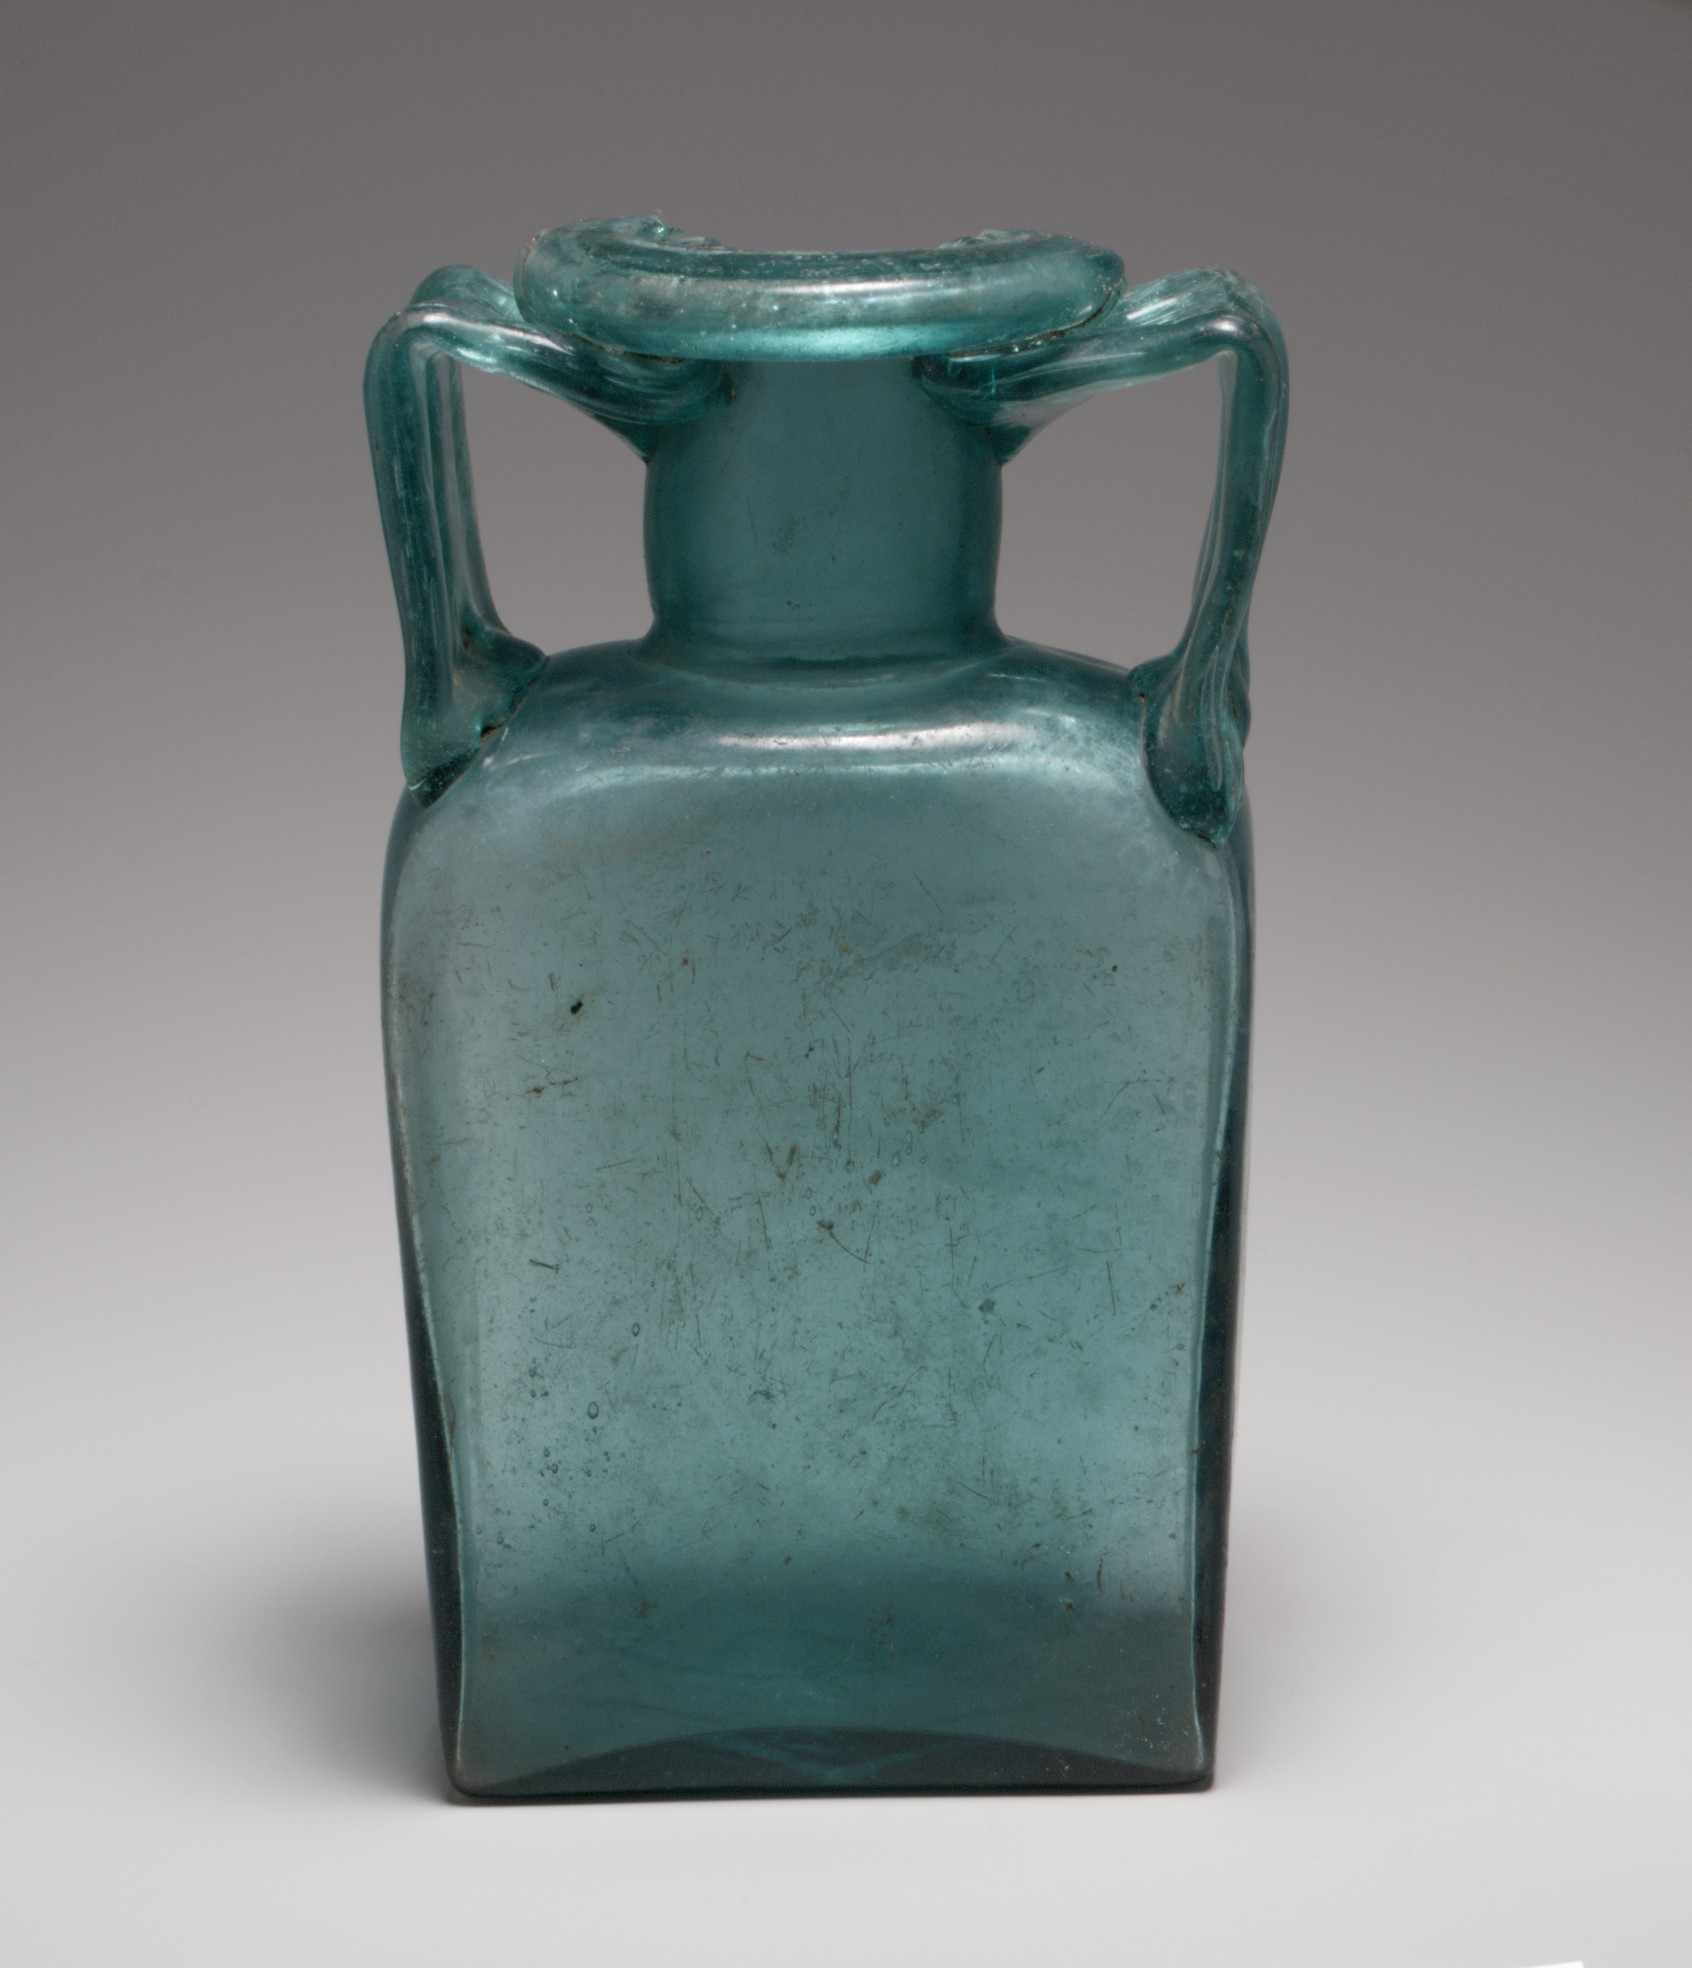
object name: bottle, rectangular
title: Glass rectangular bottle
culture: roman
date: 101-300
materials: glass